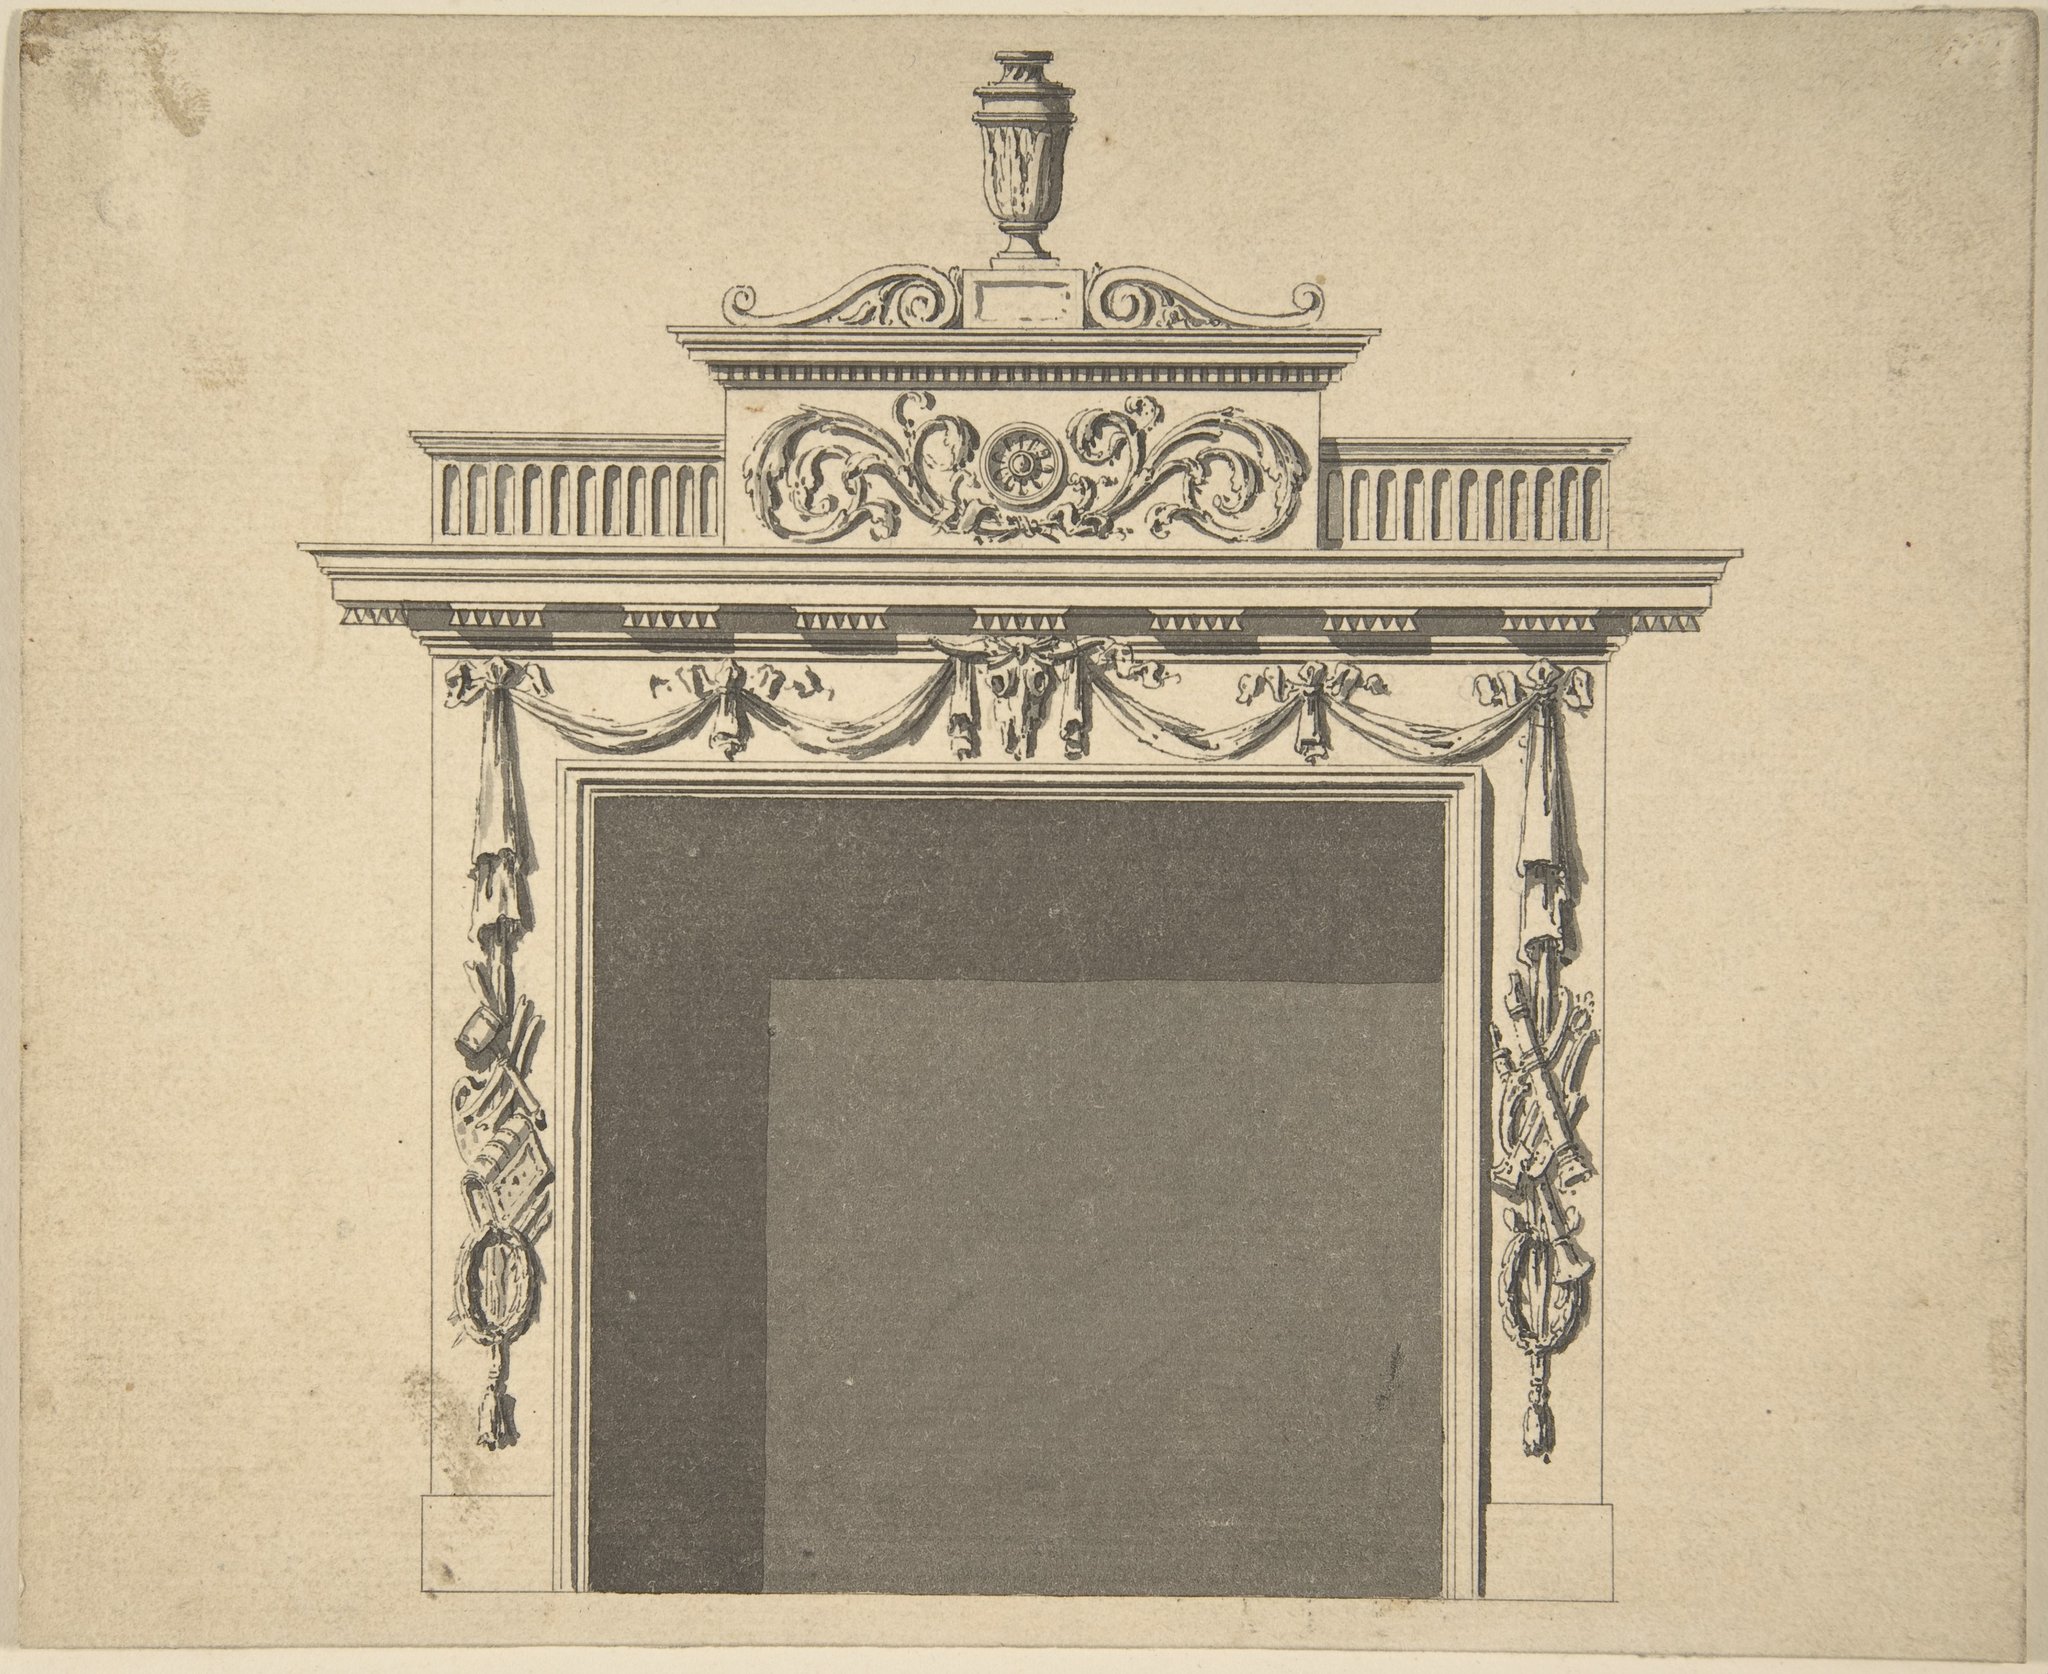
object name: drawing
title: Design for Hall Chimney-piece, Charlemont House, Dublin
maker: sir william chambers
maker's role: artist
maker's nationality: british, born sweden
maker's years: 1723-1796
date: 1762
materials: ink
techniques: brush, pen, wash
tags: fireplaces,ornament